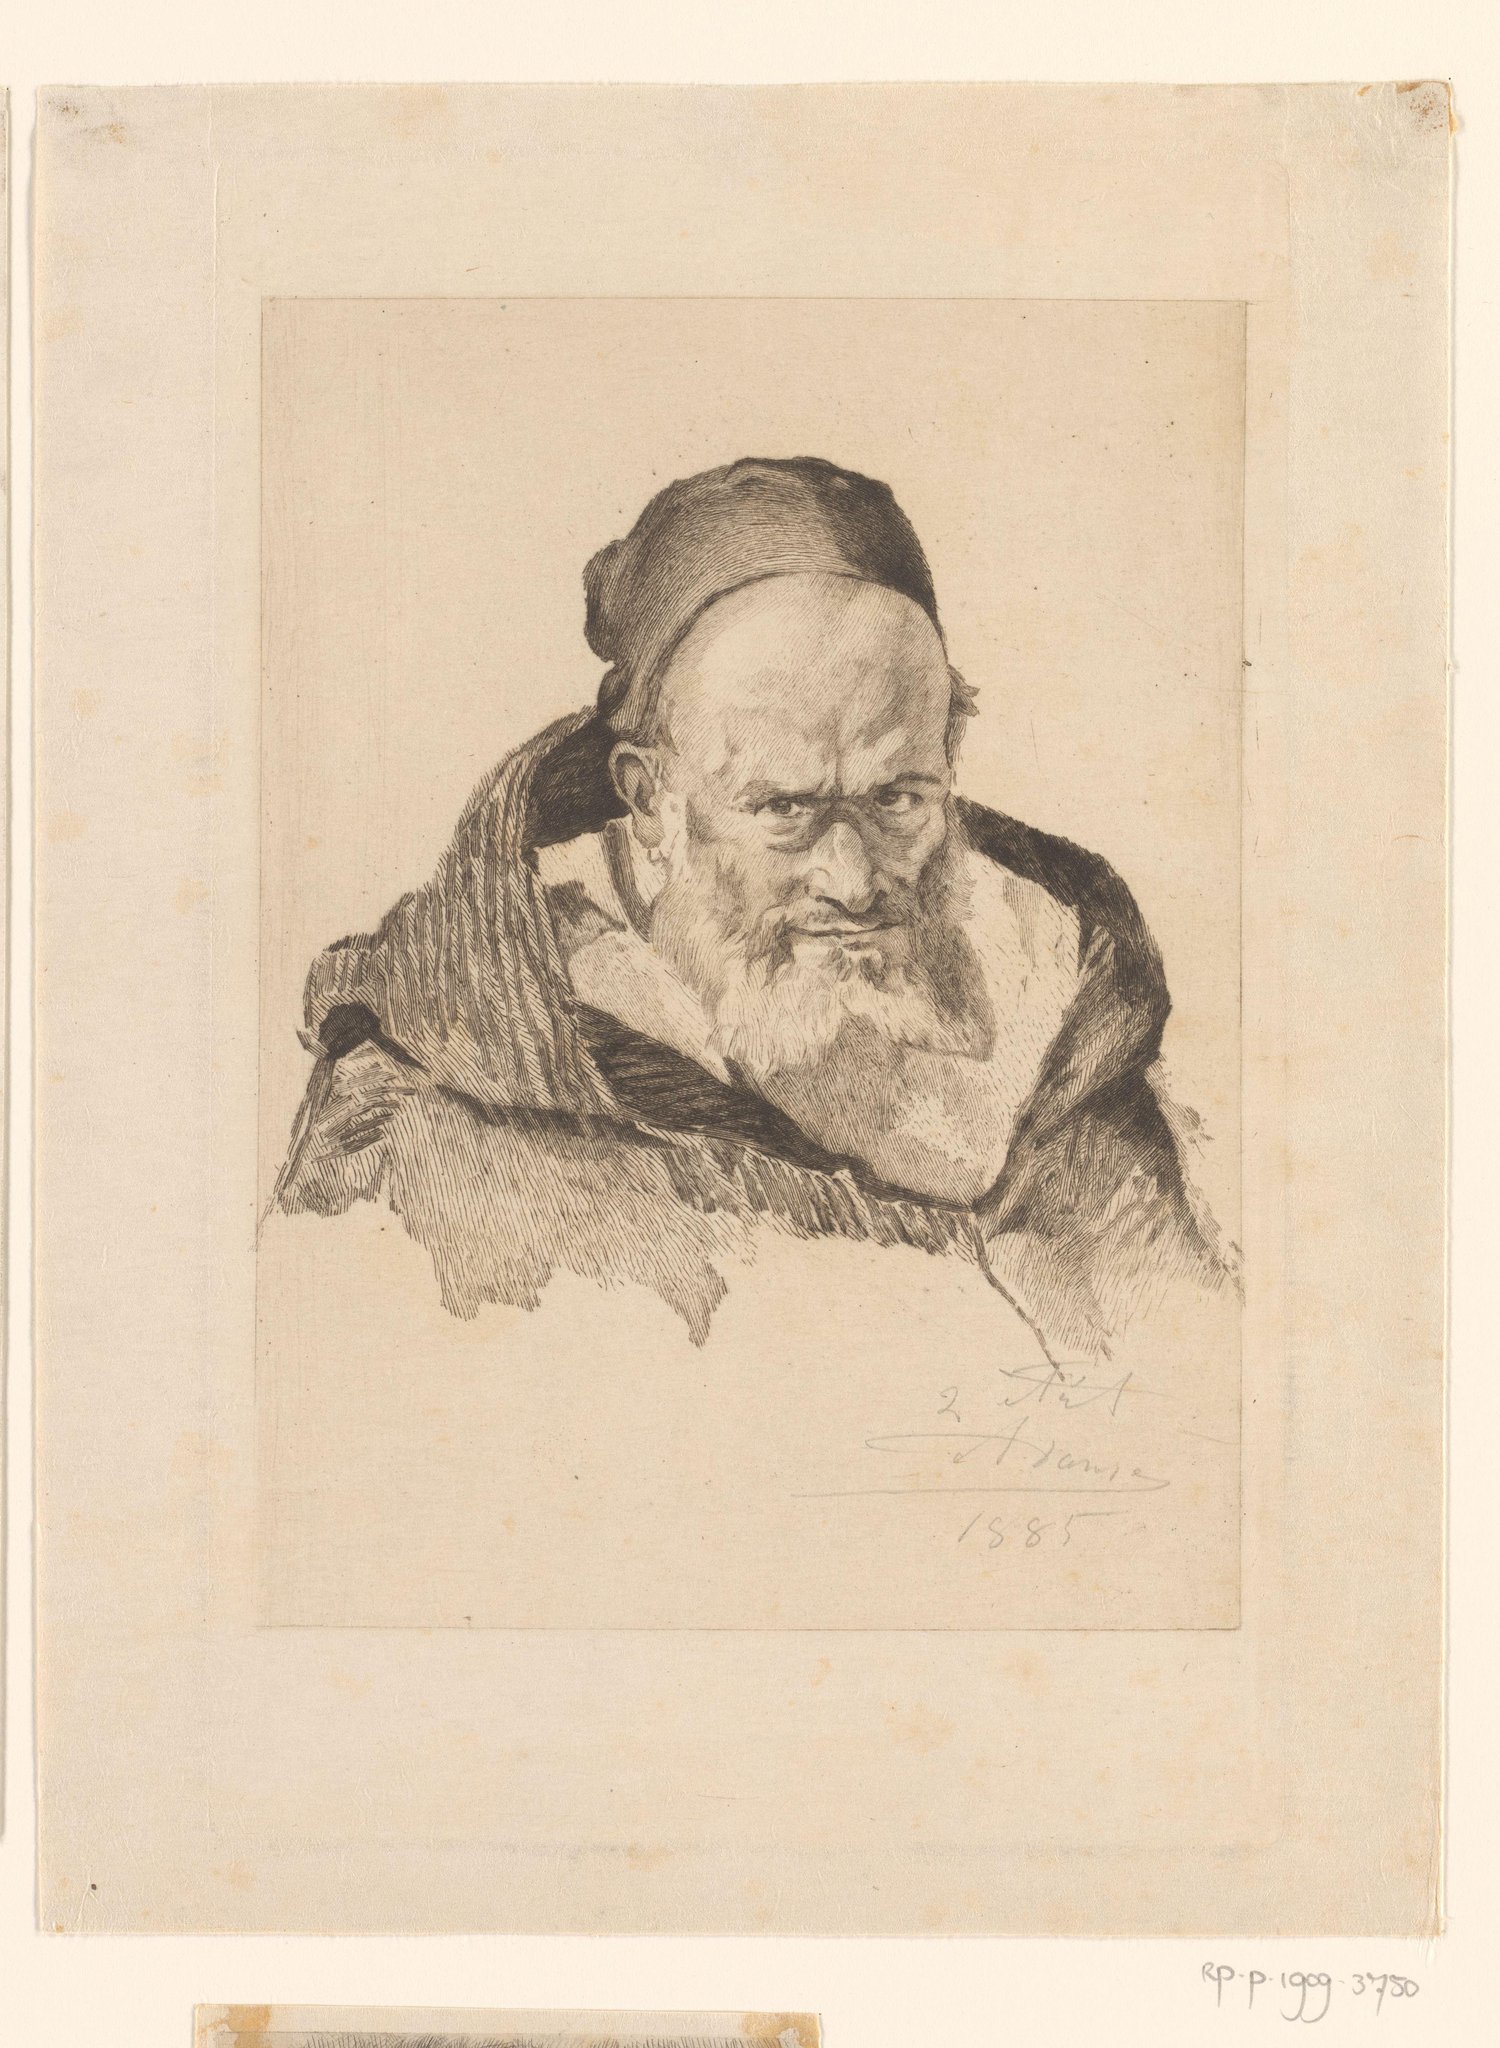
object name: print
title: Hoofd van een bebaarde man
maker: auguste danse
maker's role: print maker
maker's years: 1829-1929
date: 1885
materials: paper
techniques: etching, intaglio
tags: anonymous historical person portrayed alone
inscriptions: collector's mark: Lugt 2228, annotation: ‘2 etat’